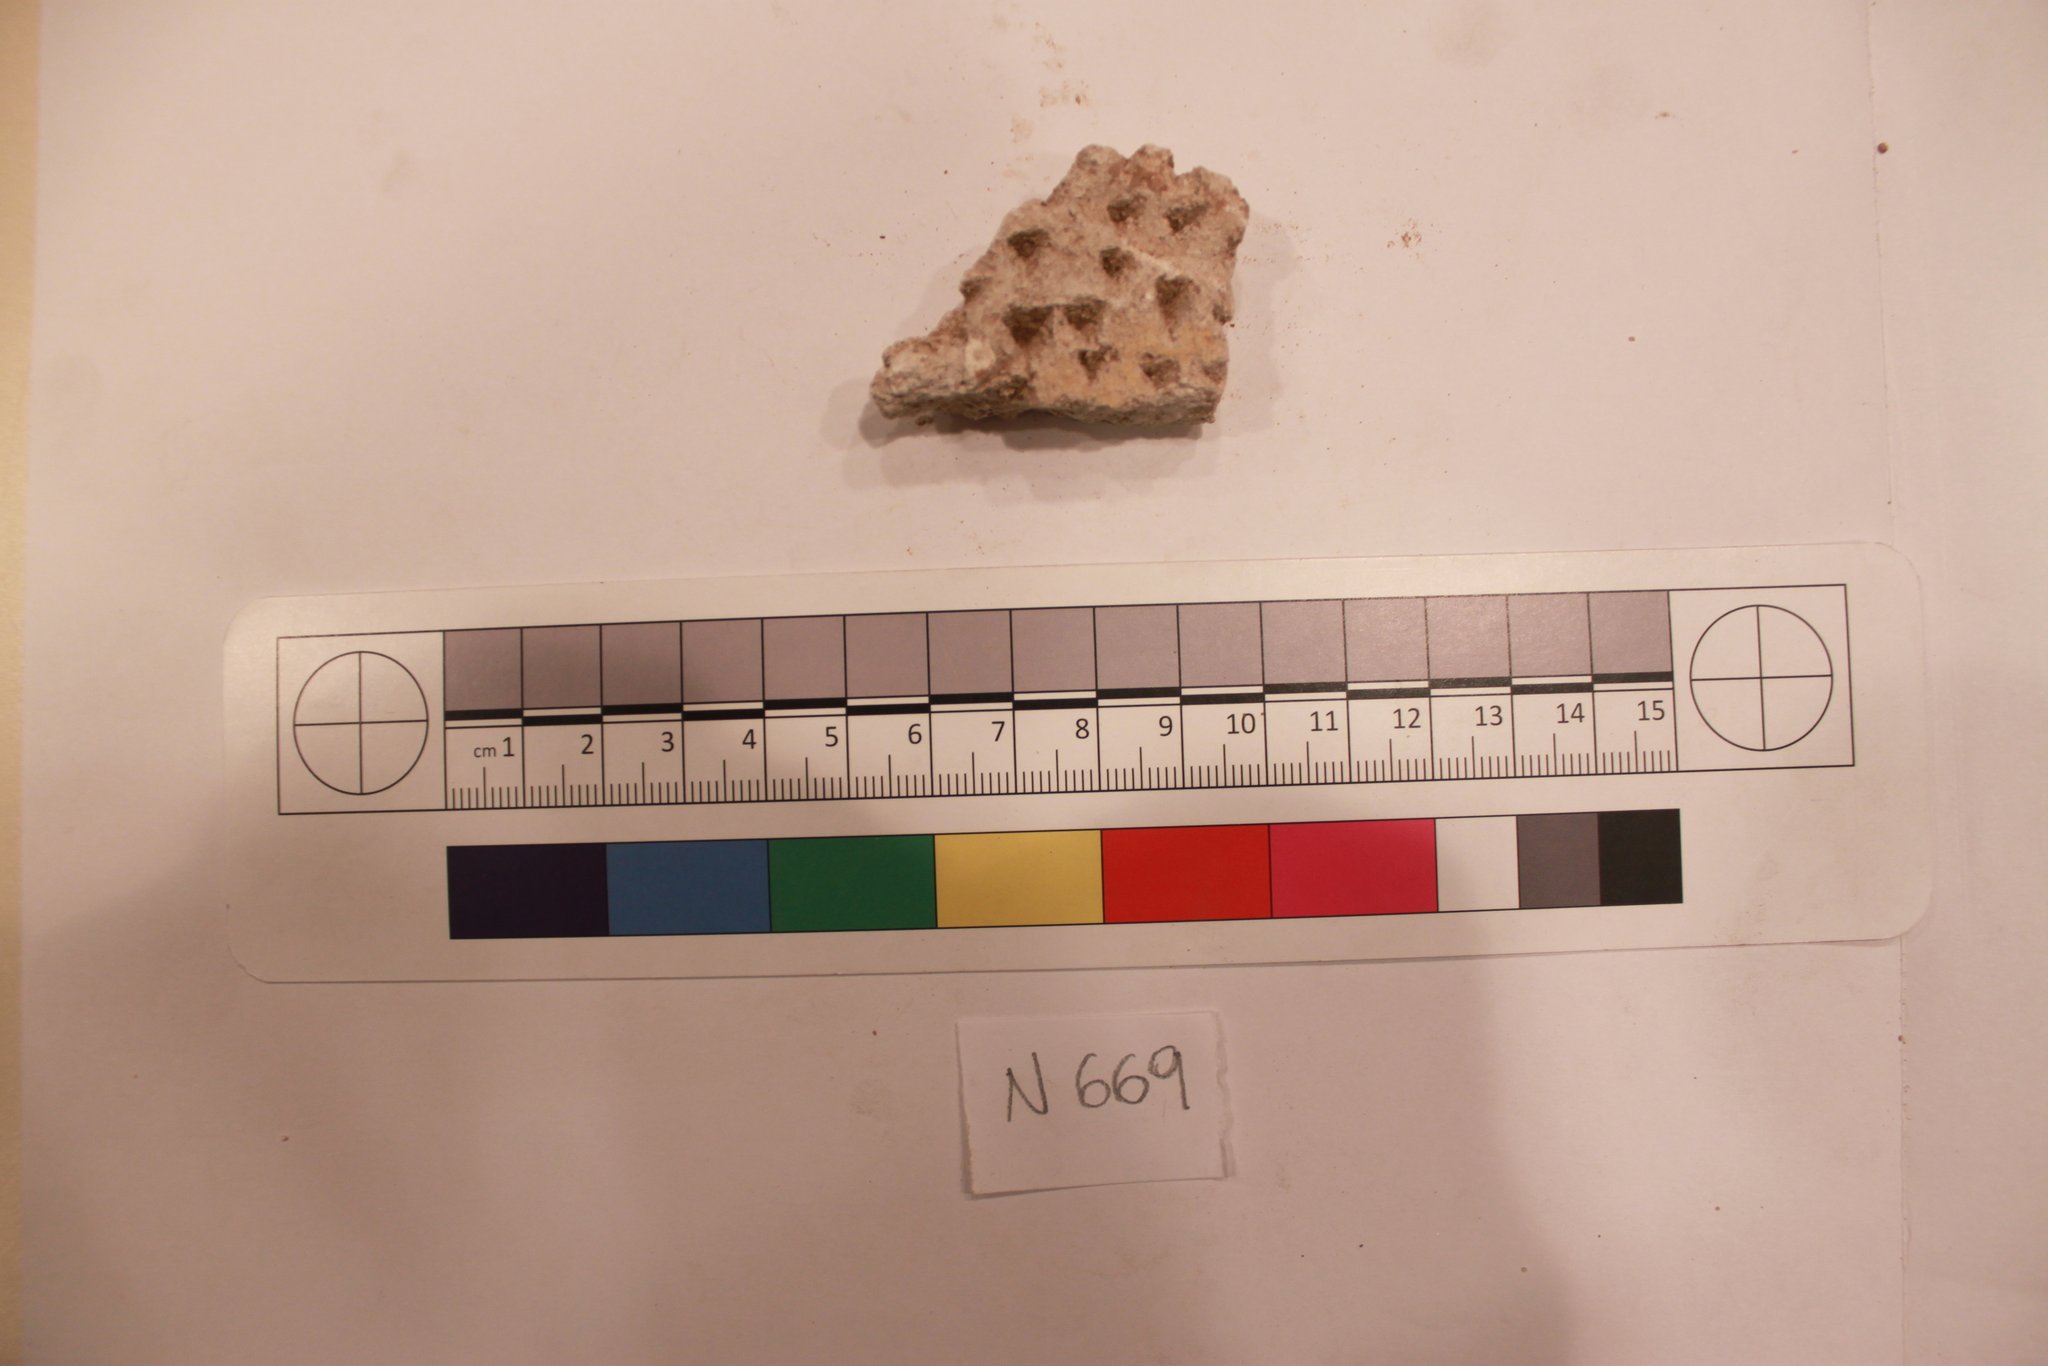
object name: fragment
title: Stucco Fragment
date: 701-1200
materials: plaster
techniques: carving, painting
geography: iran